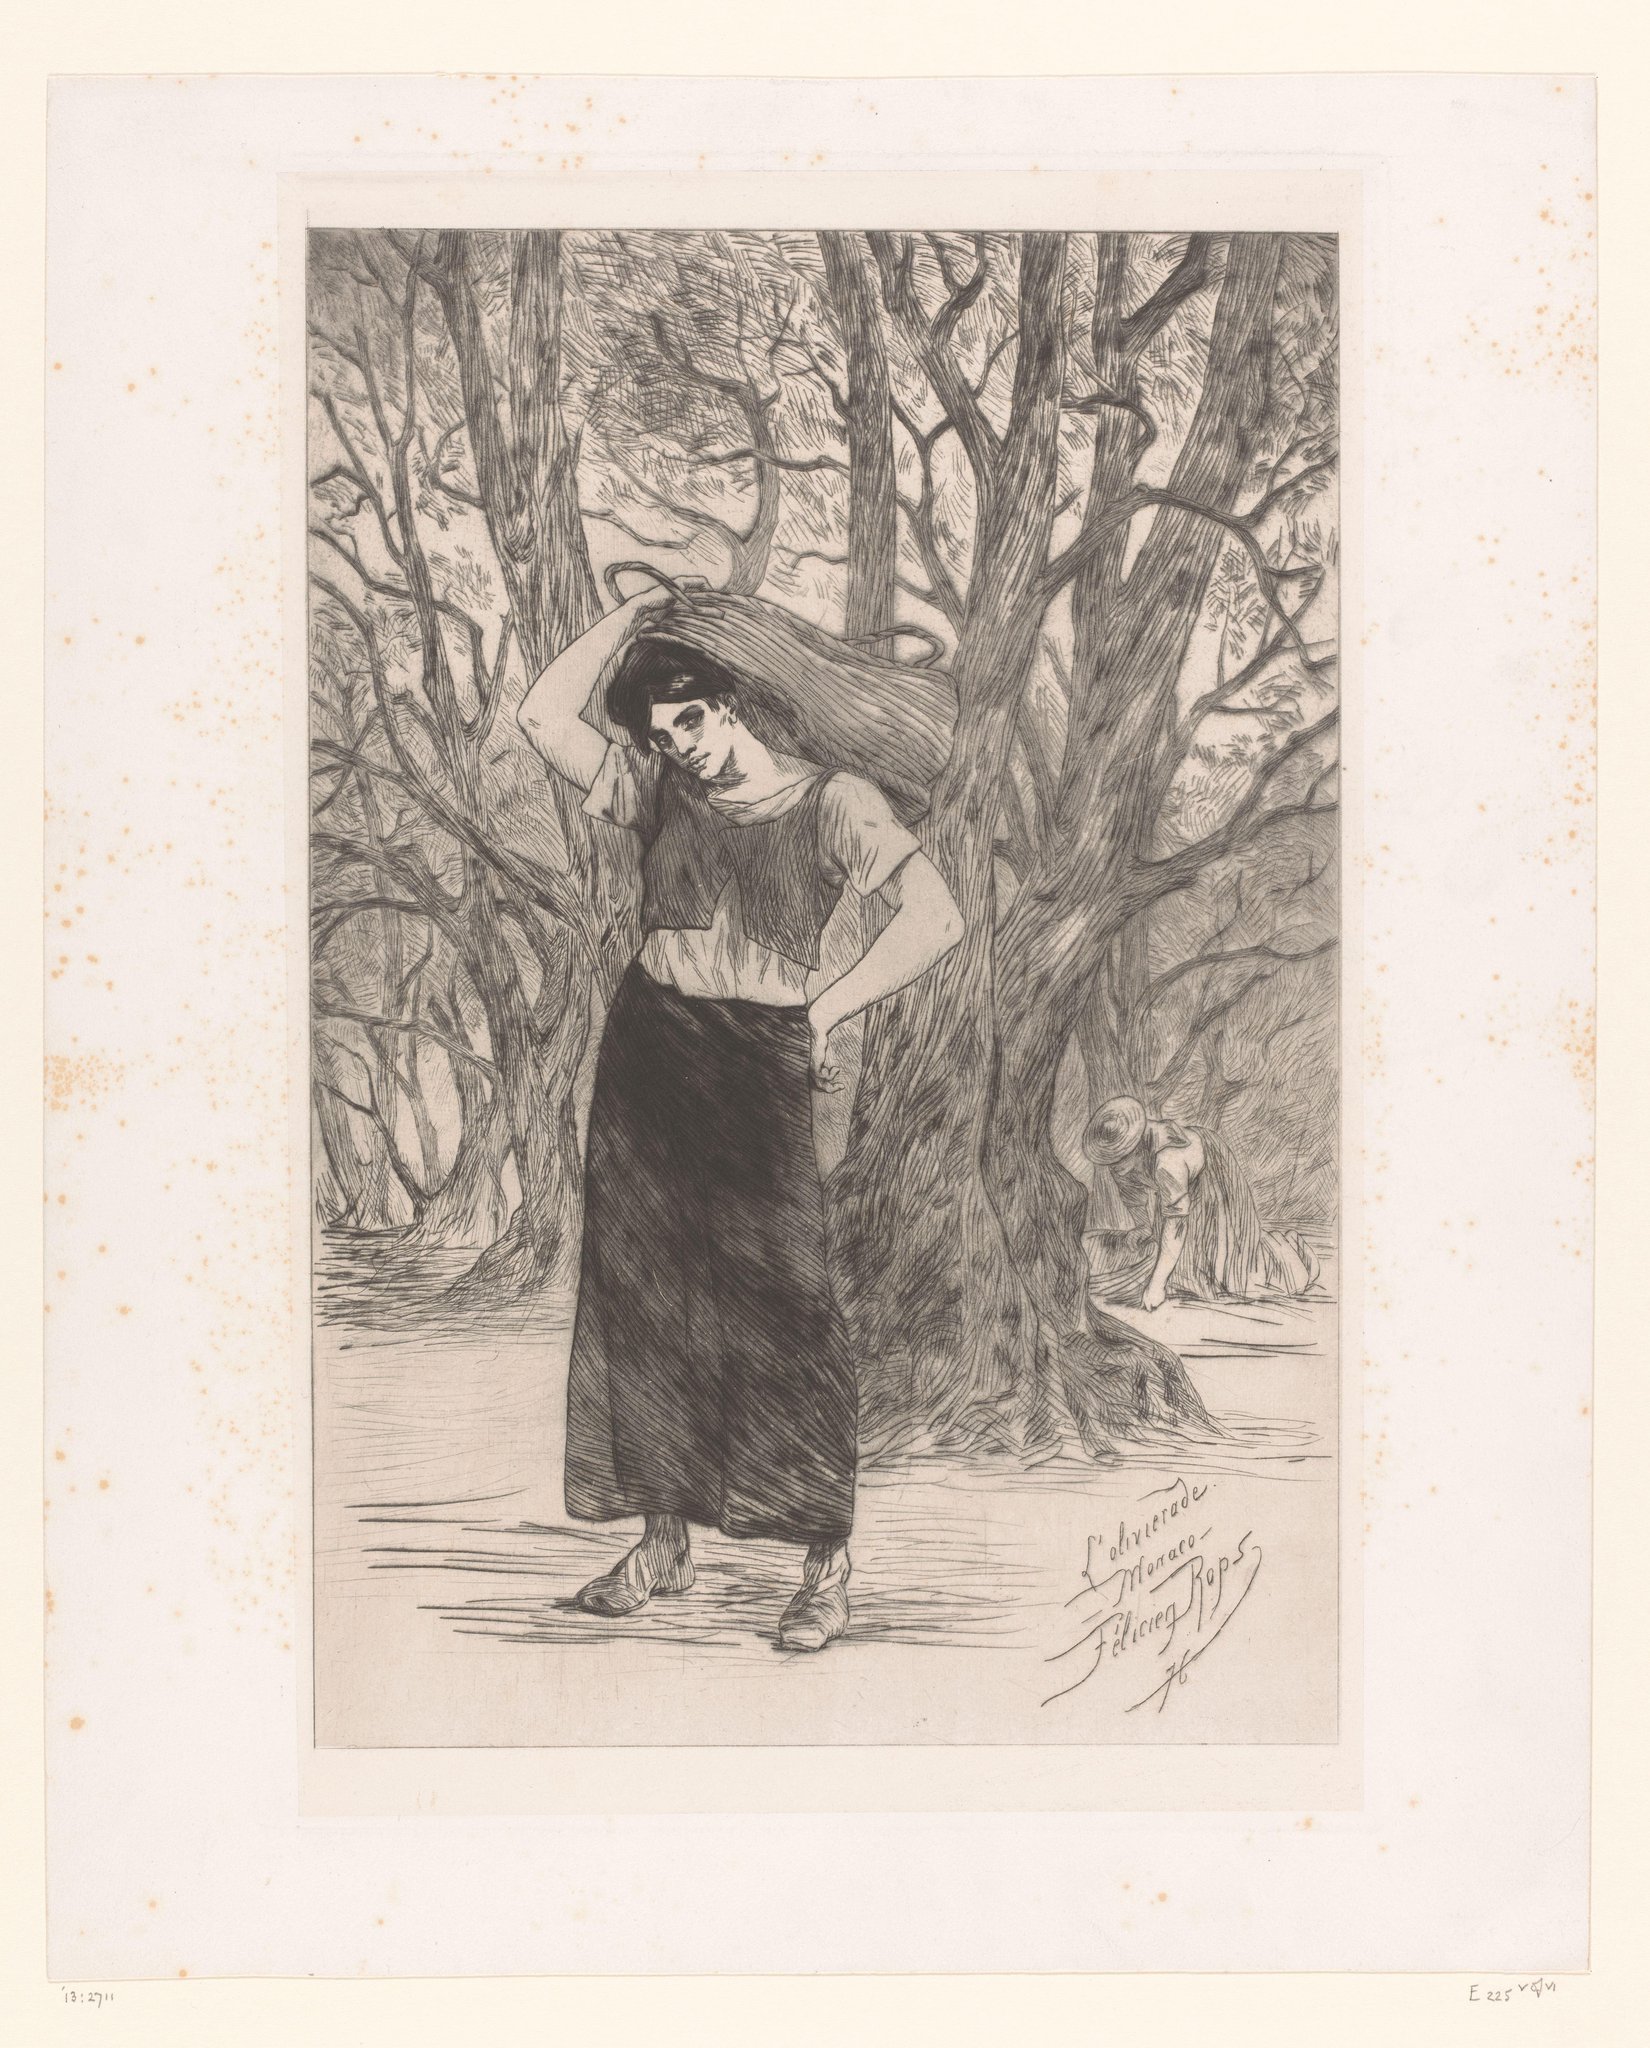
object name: print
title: À Monaco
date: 1876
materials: paper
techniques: drypoint, etching, intaglio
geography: paris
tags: fruits: olive, fruit harvest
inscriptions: collector's mark: Lugt 2228